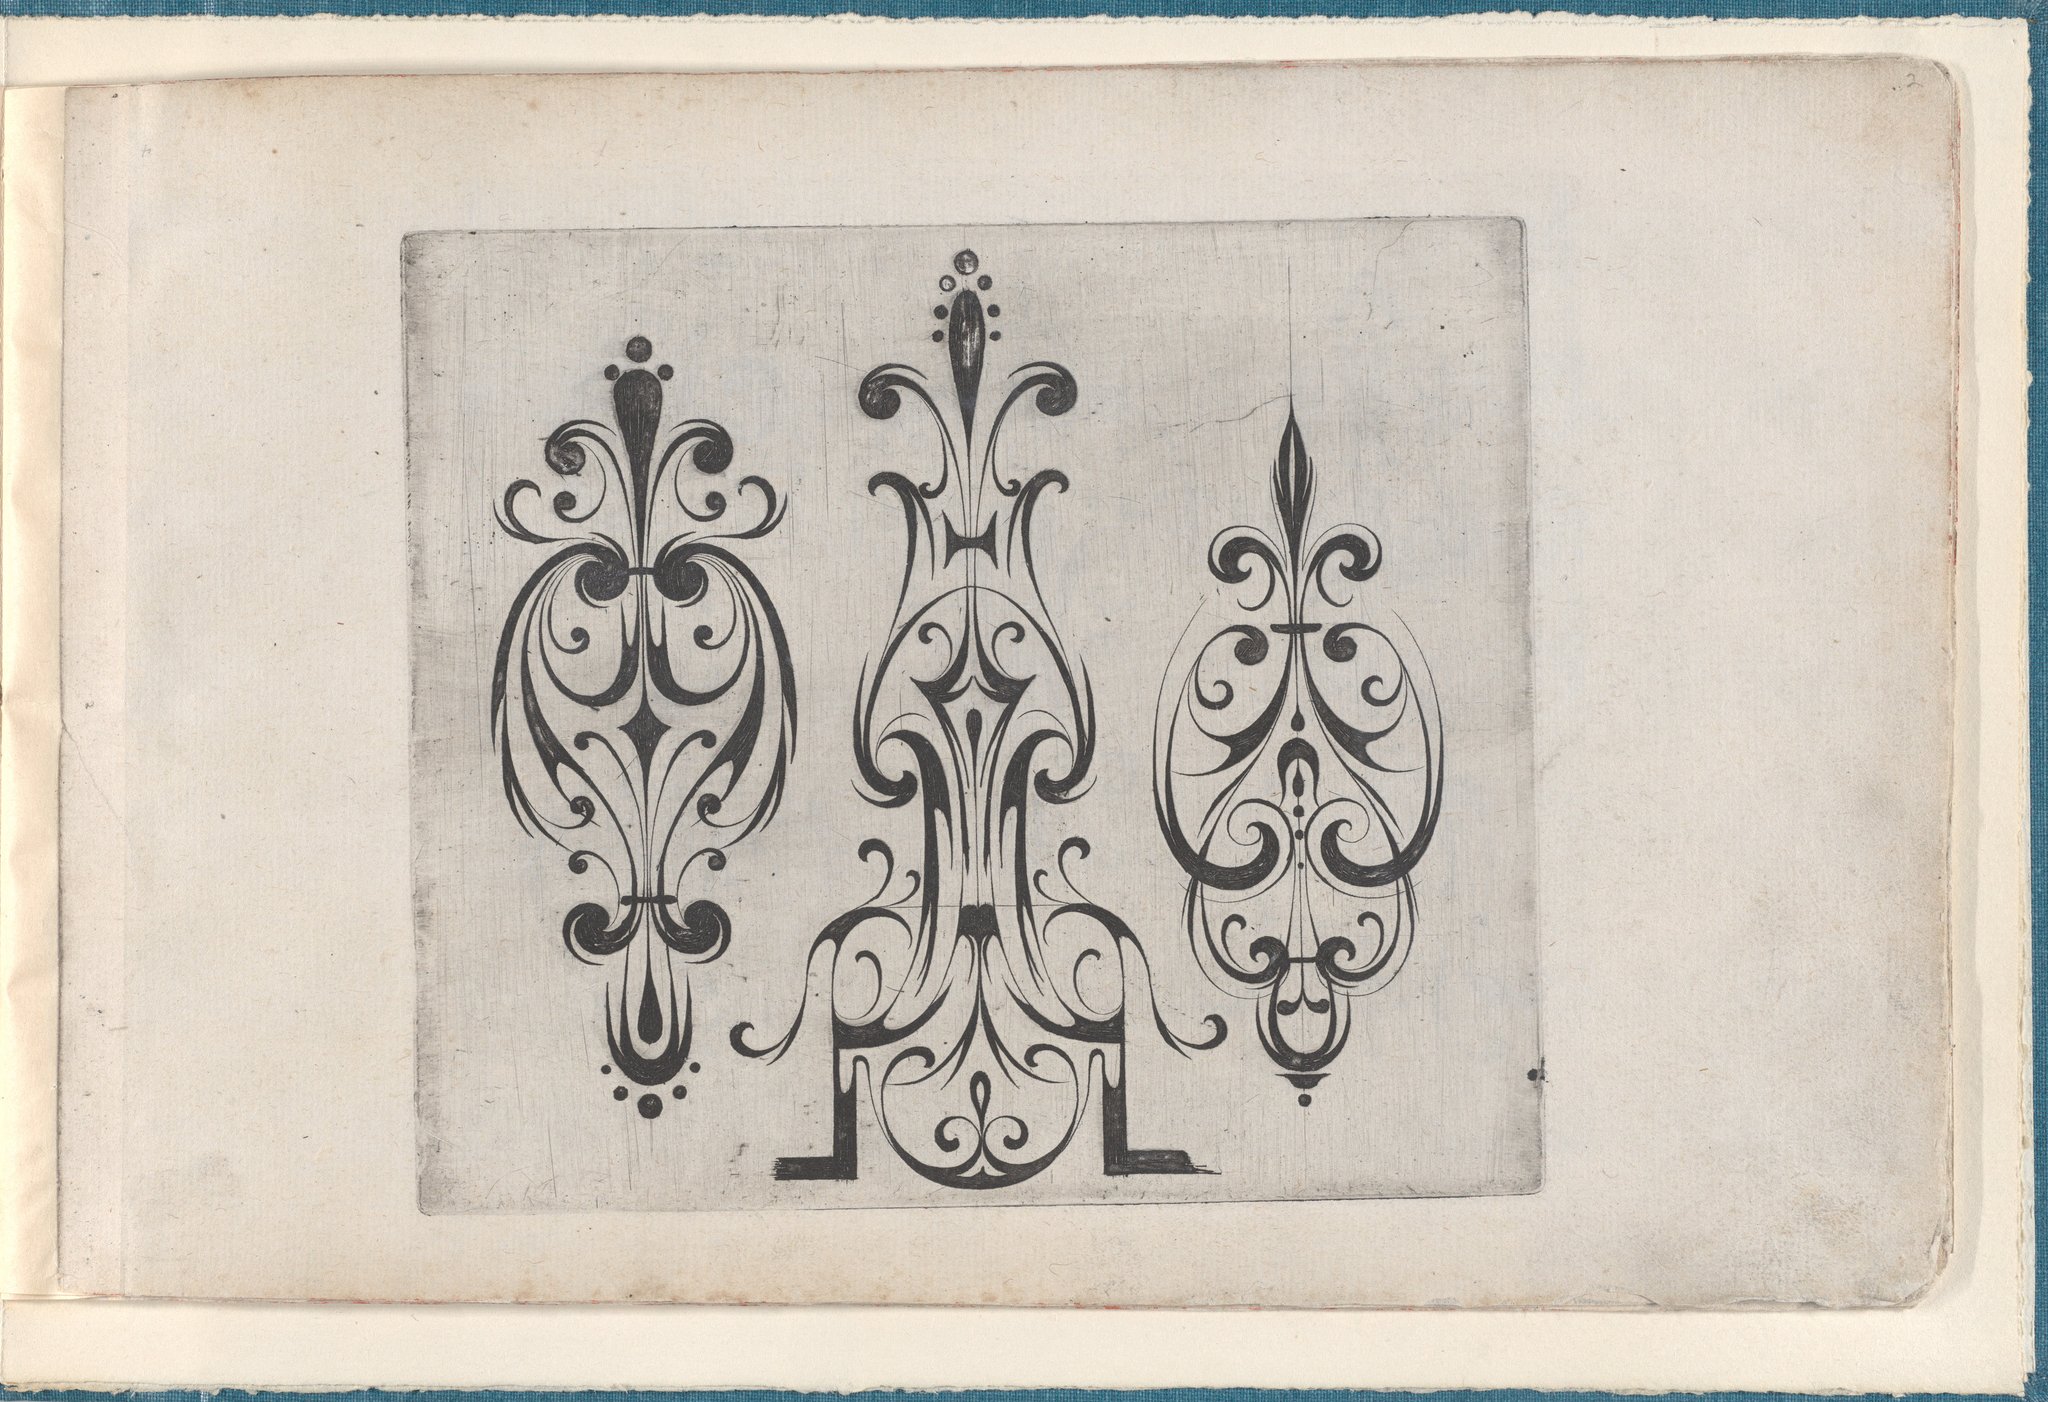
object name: album print ornament architecture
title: Plate from "Grateske voer golt smeden Schrijnwerkers Ende andere des nodich hebbende"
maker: meinert gelijs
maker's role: artist and engraver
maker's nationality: dutch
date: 1610-1630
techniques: embroidery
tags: ornament